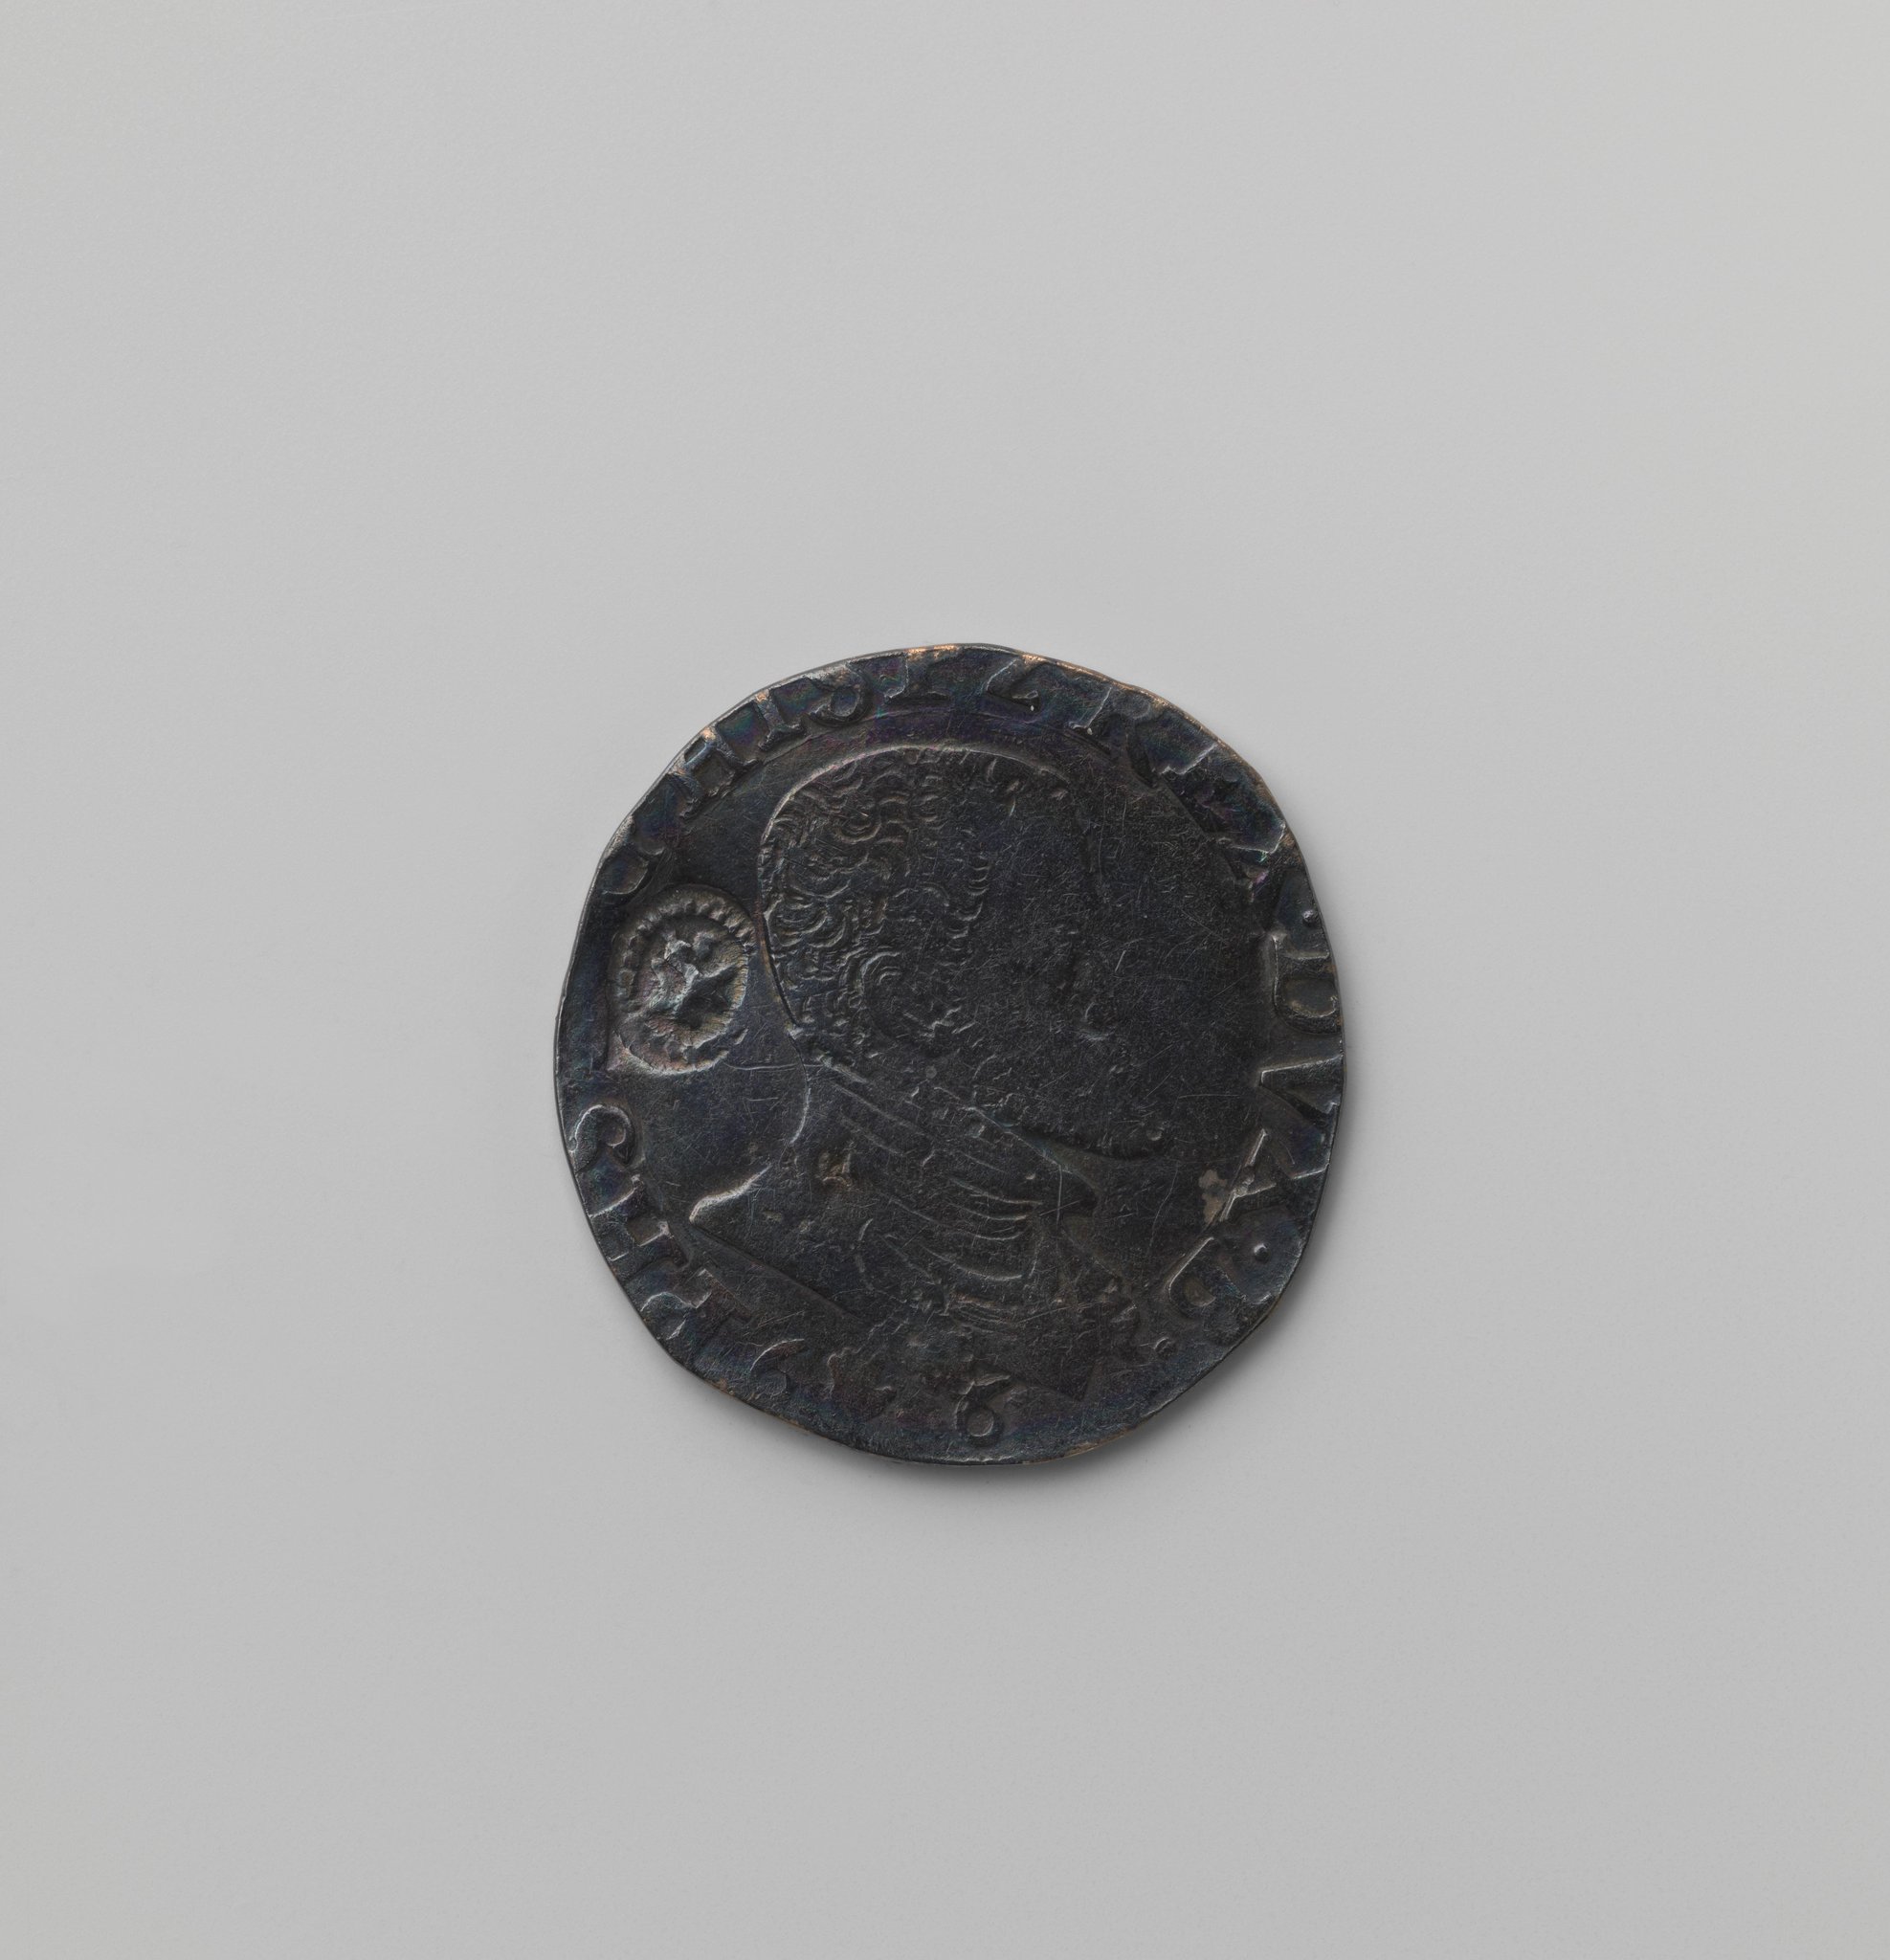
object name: coin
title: Vijfde philipsdaalder uit Brabant van Philips II, 1566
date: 1566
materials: silver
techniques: striking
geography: antwerp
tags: philip ii of spain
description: Zilveren munt. Voorzijde: hoofd van Philips II naar rechts. Jaartal 66, waartussen hand, in omschrift.Keerzijde: tussen twee vuurijzers met vonken gekroond wapenschild op stokkenkruis. Op voorzijde klop: leeuw in ovale parelrand: Holland.